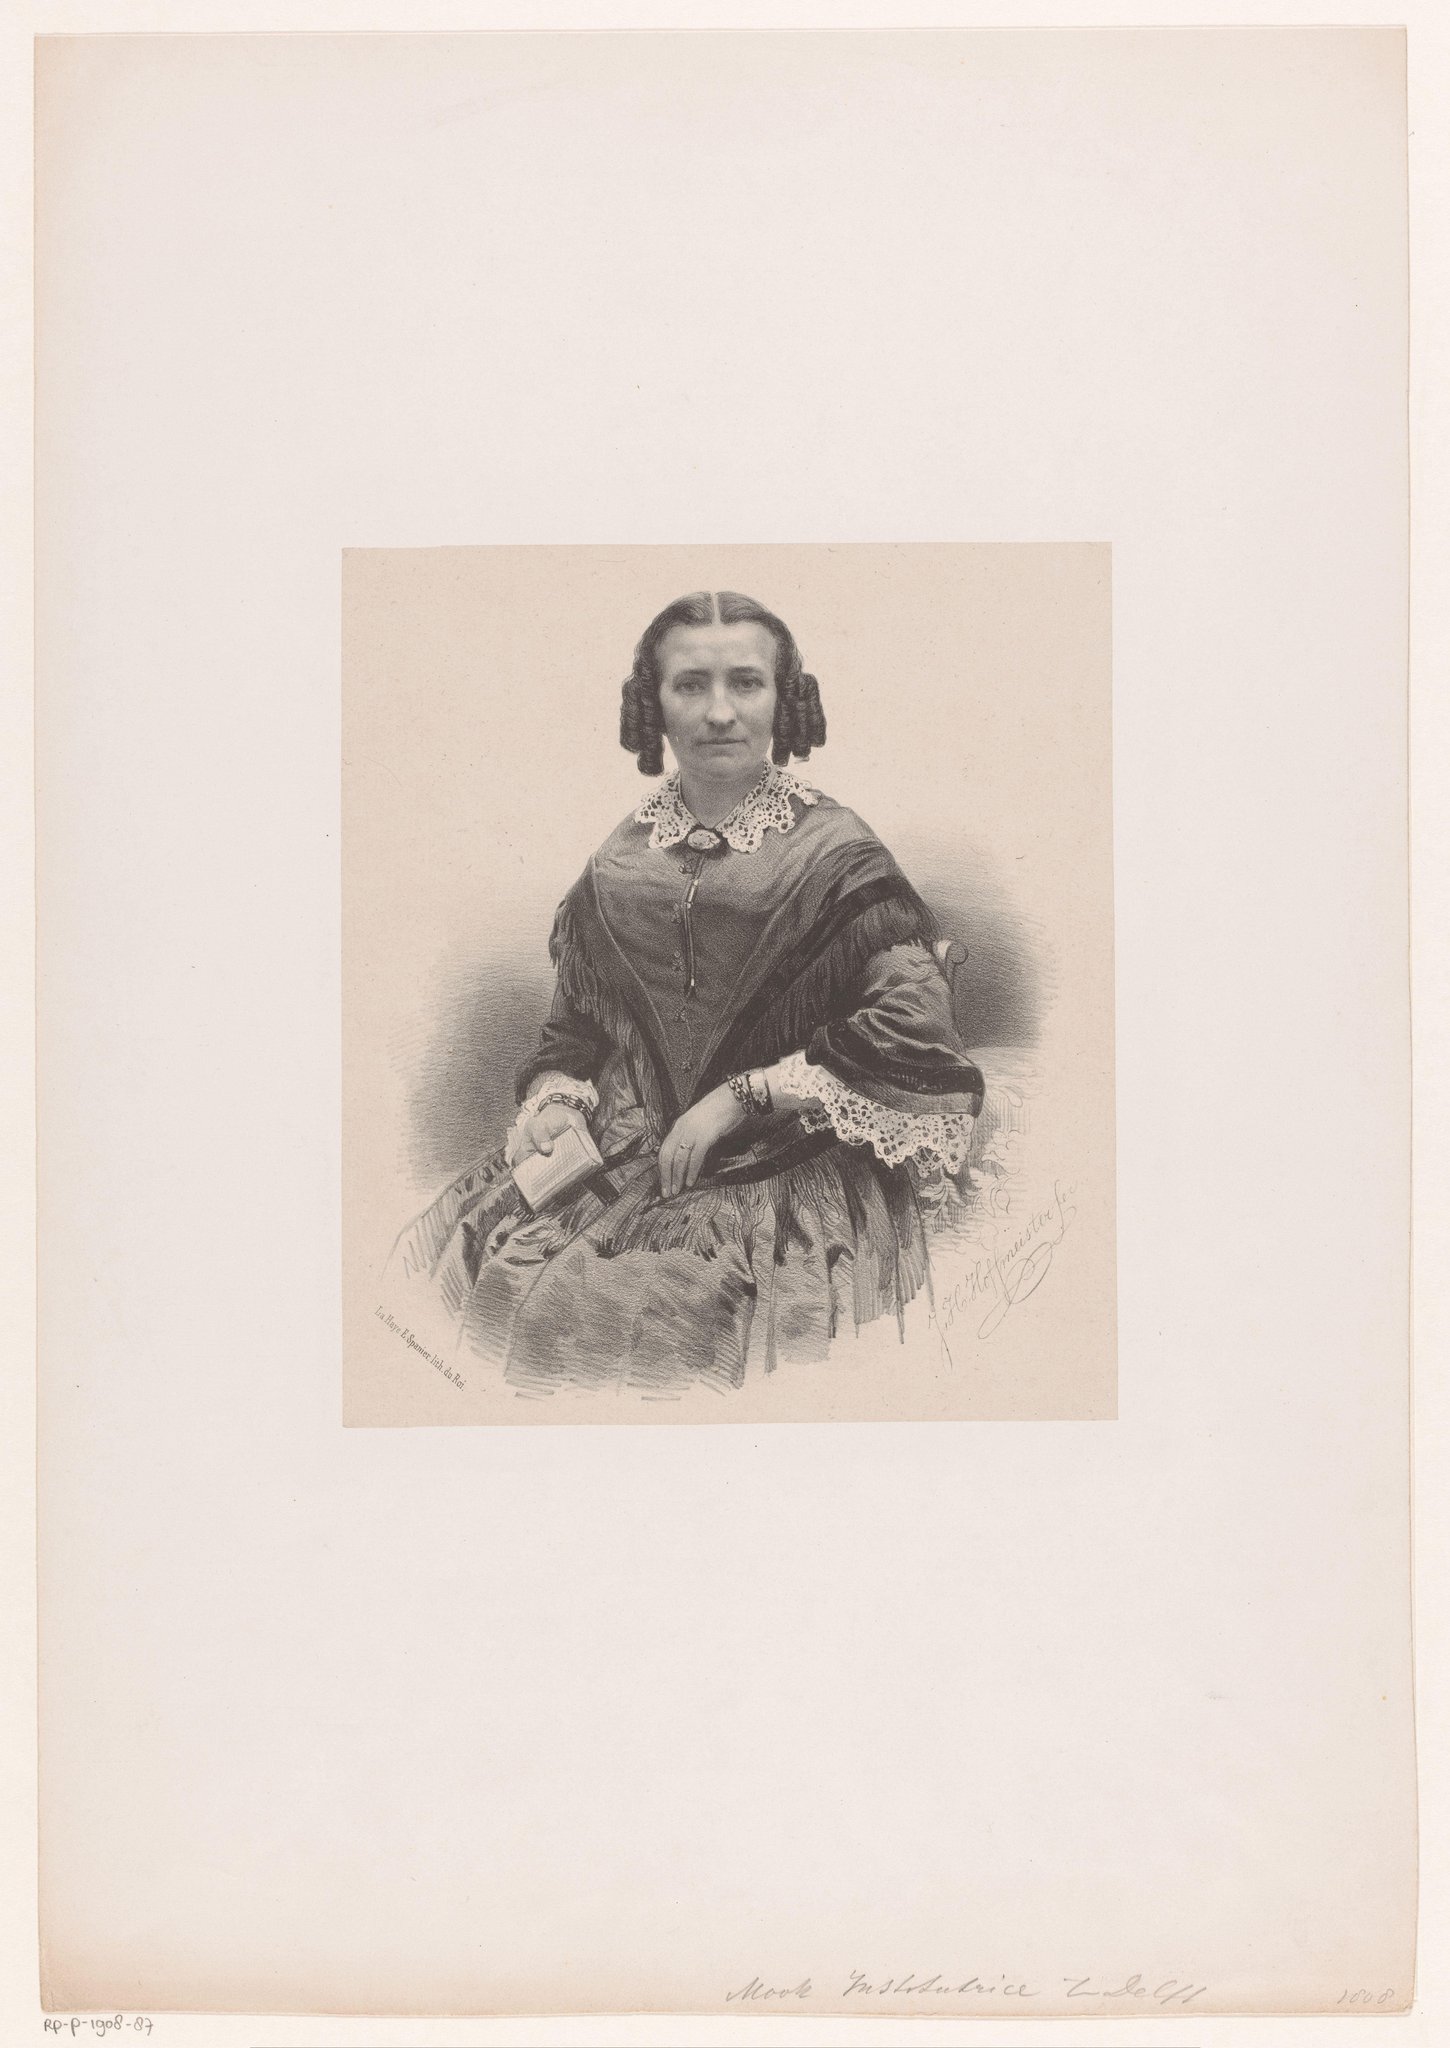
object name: print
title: Portret van een onbekende vrouw, mogelijk mevrouw Mook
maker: johan hendrik hoffmeister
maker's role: print maker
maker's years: 1823-1904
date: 1851-1883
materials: paper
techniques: lithograph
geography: the hague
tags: historical persons - bb - woman (+ half-length portrait)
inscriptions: collector's mark: Lugt 2228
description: Volgens het inventarisboek is dit een portret van mevrouw Mook, onderwijzeres te Delft, evenals RP-P-1908-86.